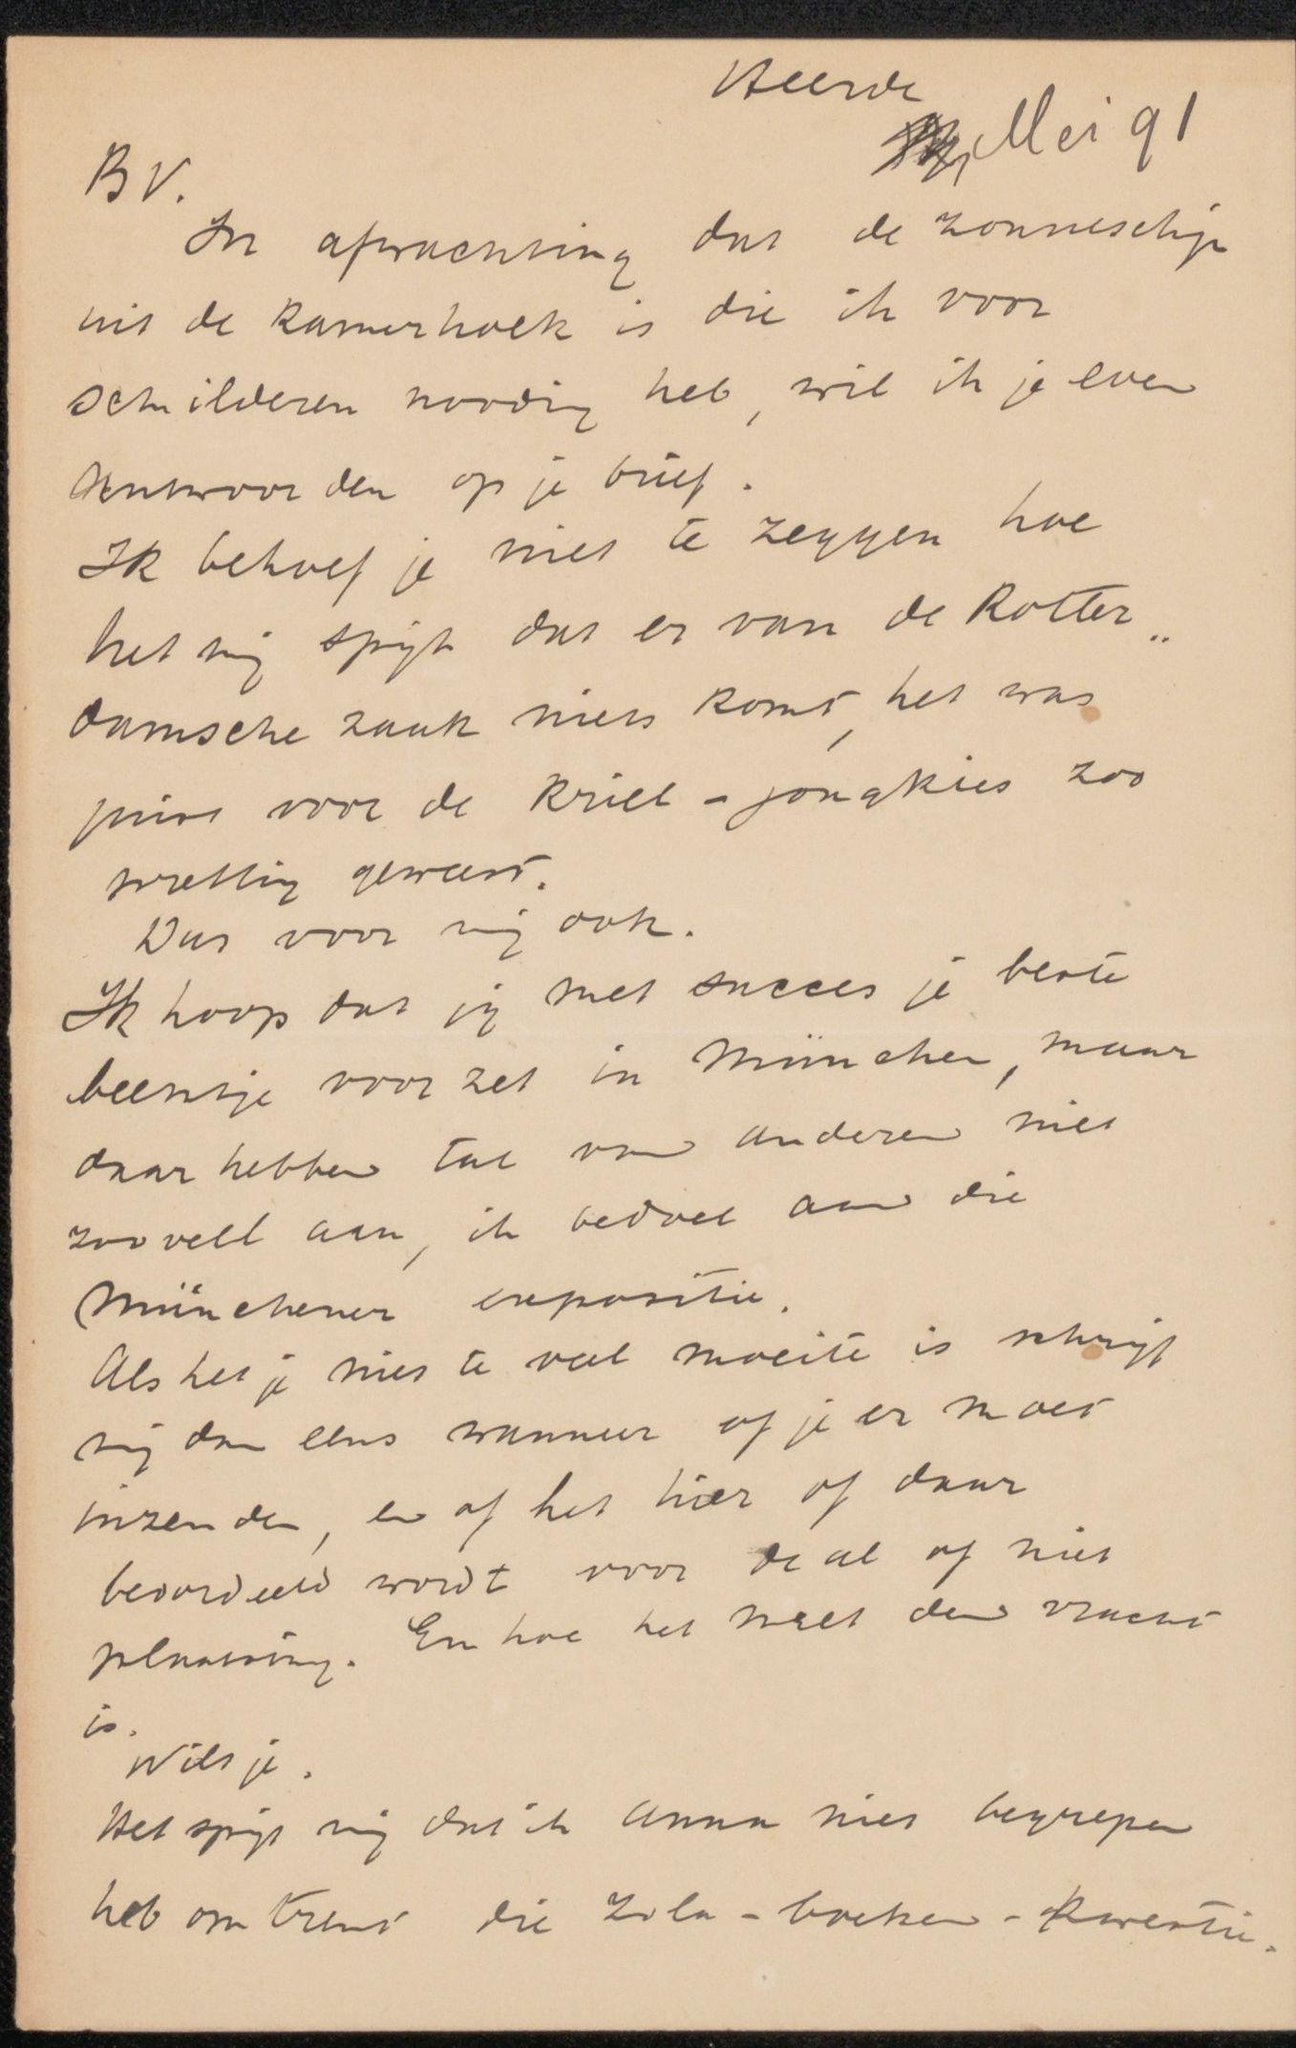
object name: letter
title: Brief aan Jan Veth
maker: richard nicolaüs roland holst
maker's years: 1868-1938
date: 1805-1891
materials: ink, paper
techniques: pen, writing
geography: heerde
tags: dordrecht, painter, print maker, draughtsman, designer, jan veth, emile zola, the hague, literature ~ arts, painting (including book-illumination, miniature-painting), exhibition ~ art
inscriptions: collector's mark: ‘RPK’, watermark